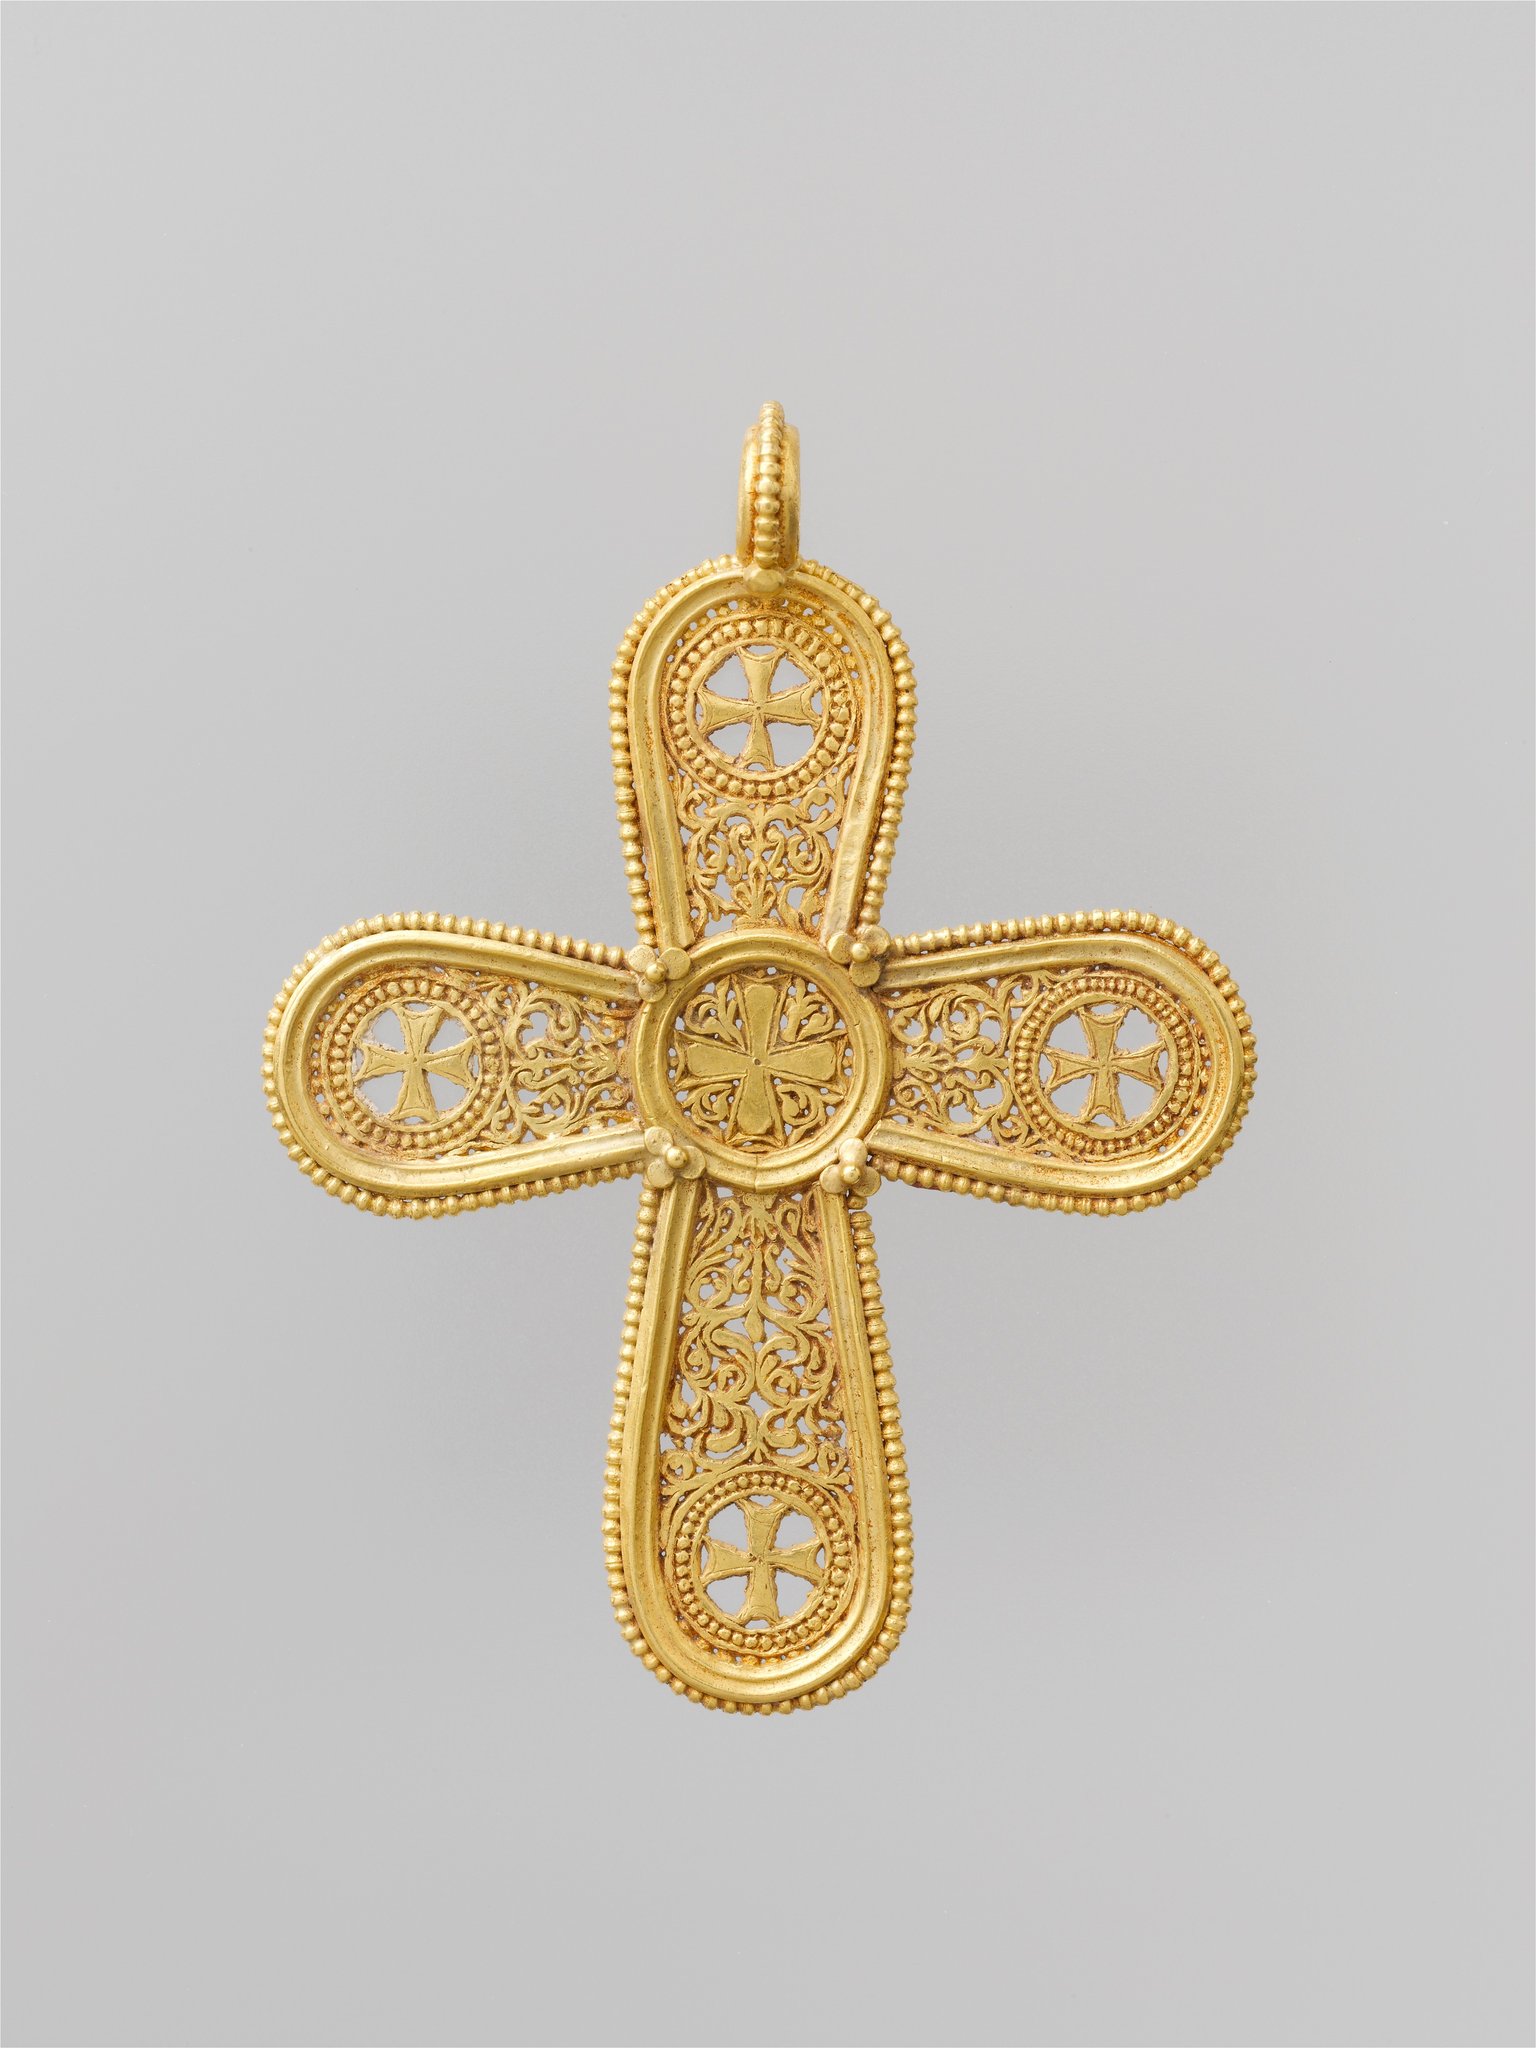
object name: pendant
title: Gold Cross Pendant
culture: byzantine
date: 500-700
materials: gold